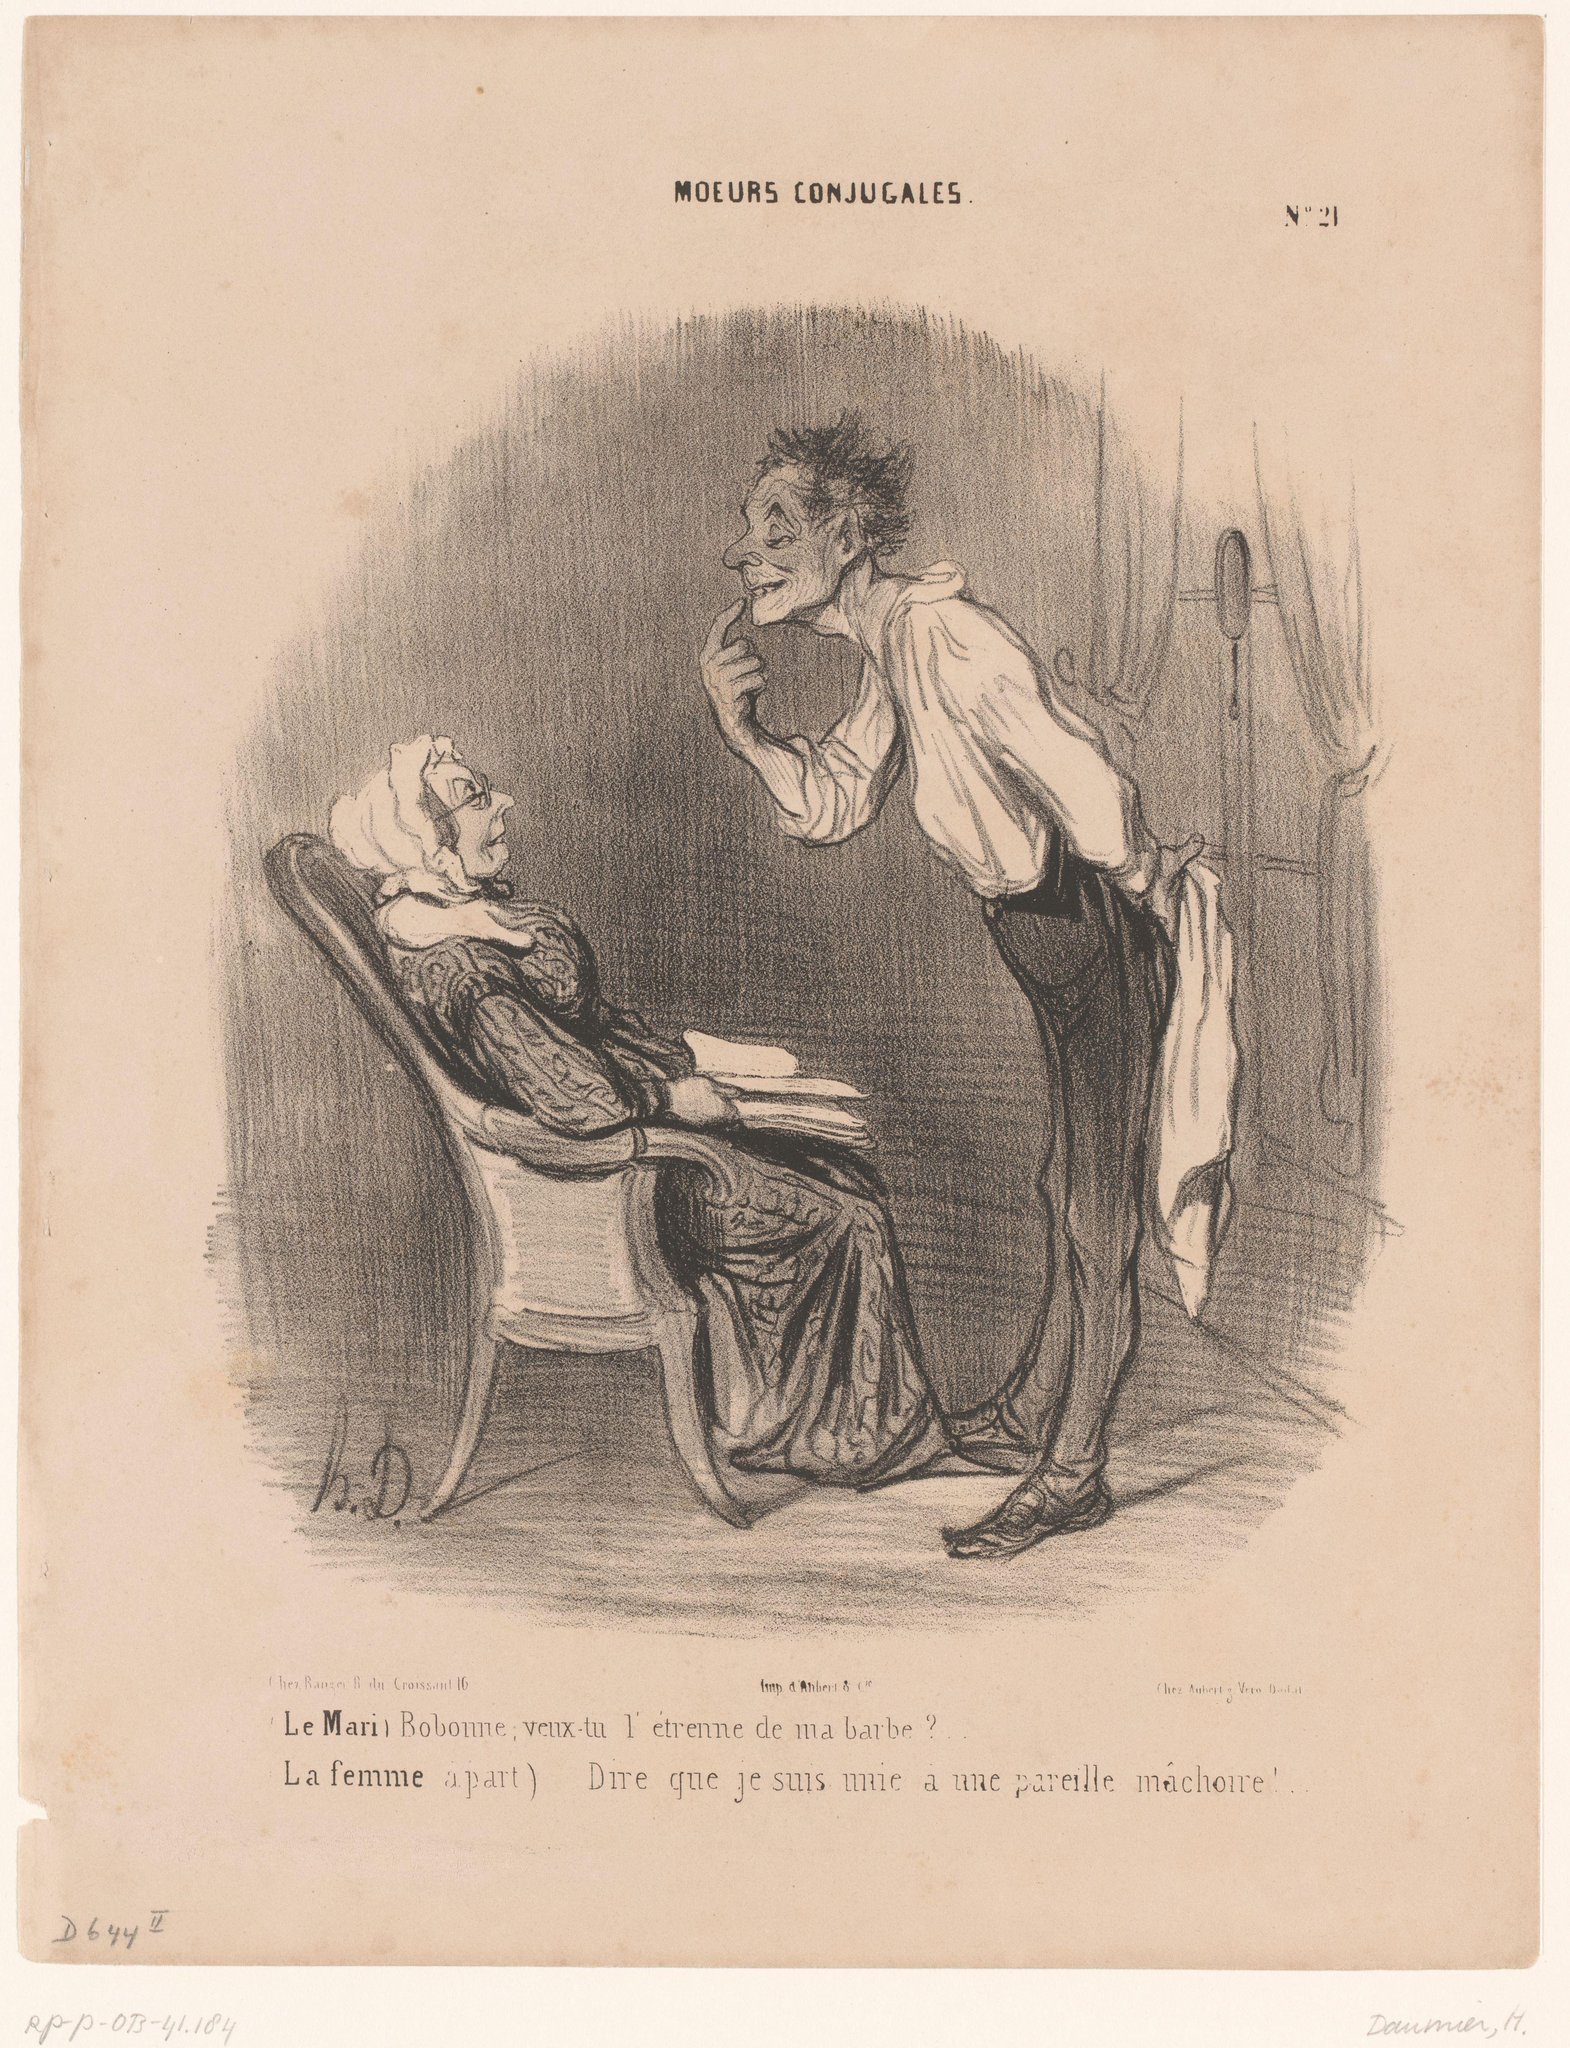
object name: cartoon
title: Moeurs conjugales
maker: honoré daumier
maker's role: draughtsman, painter, print maker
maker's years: 1808-1879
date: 1840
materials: paper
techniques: lithograph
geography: paris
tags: caricatures (human types), parts of the face (chin), marriage, married couple, 'matrimonium'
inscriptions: collector's mark: Lugt 2228a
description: Prent gebruikt voor: Le Charivari, 29 maart 1840.